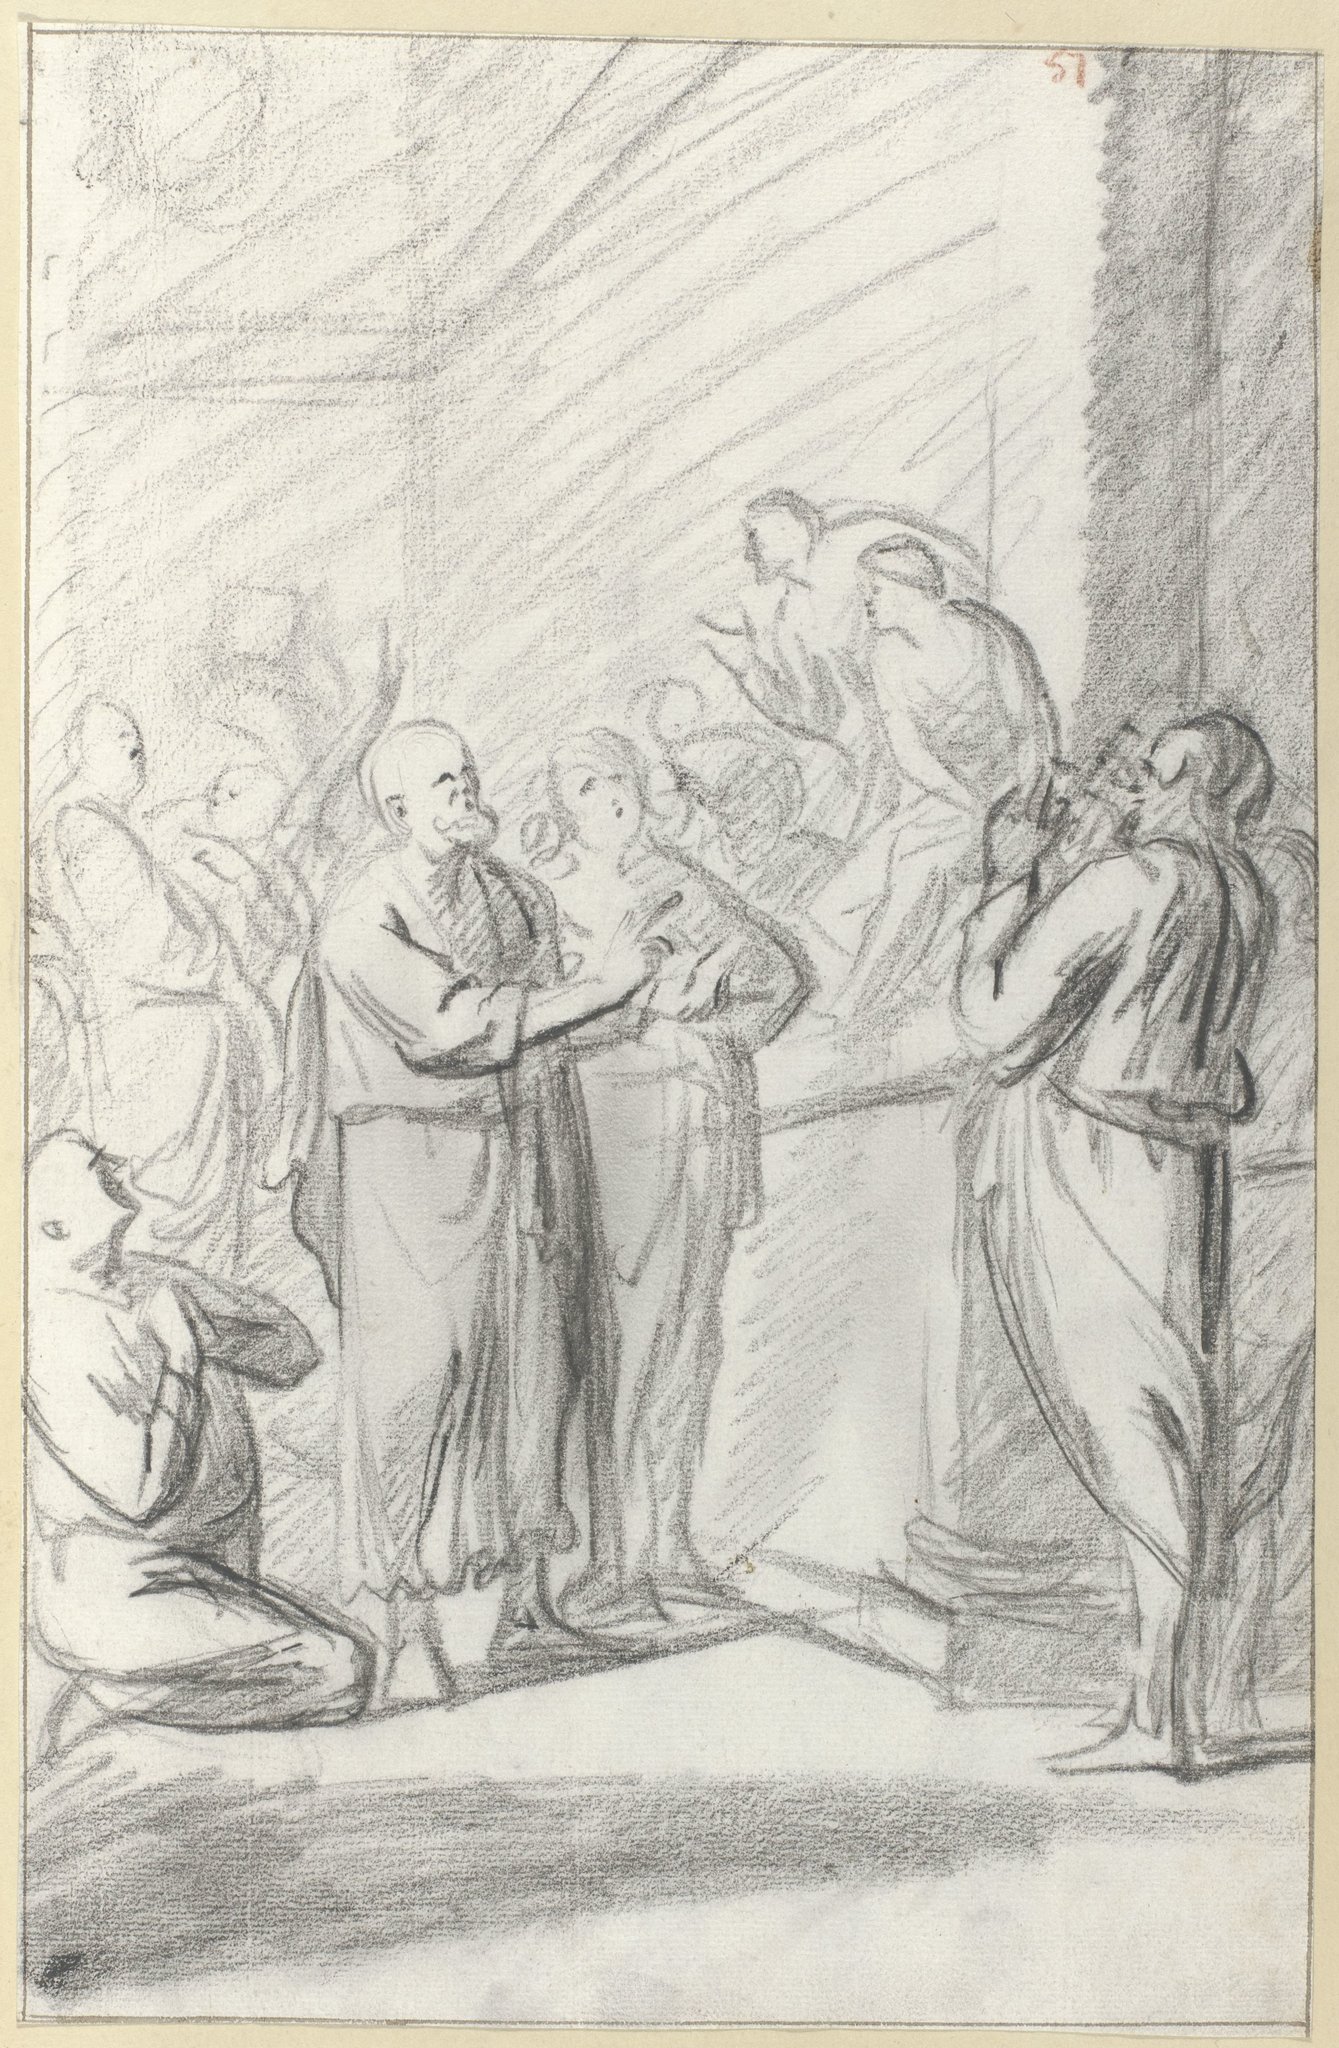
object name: drawing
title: Petrus spreekt tot het volk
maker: pieter fransz de grebber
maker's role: painter, print maker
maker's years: 1600-1653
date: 1610-1652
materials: chalk, paper